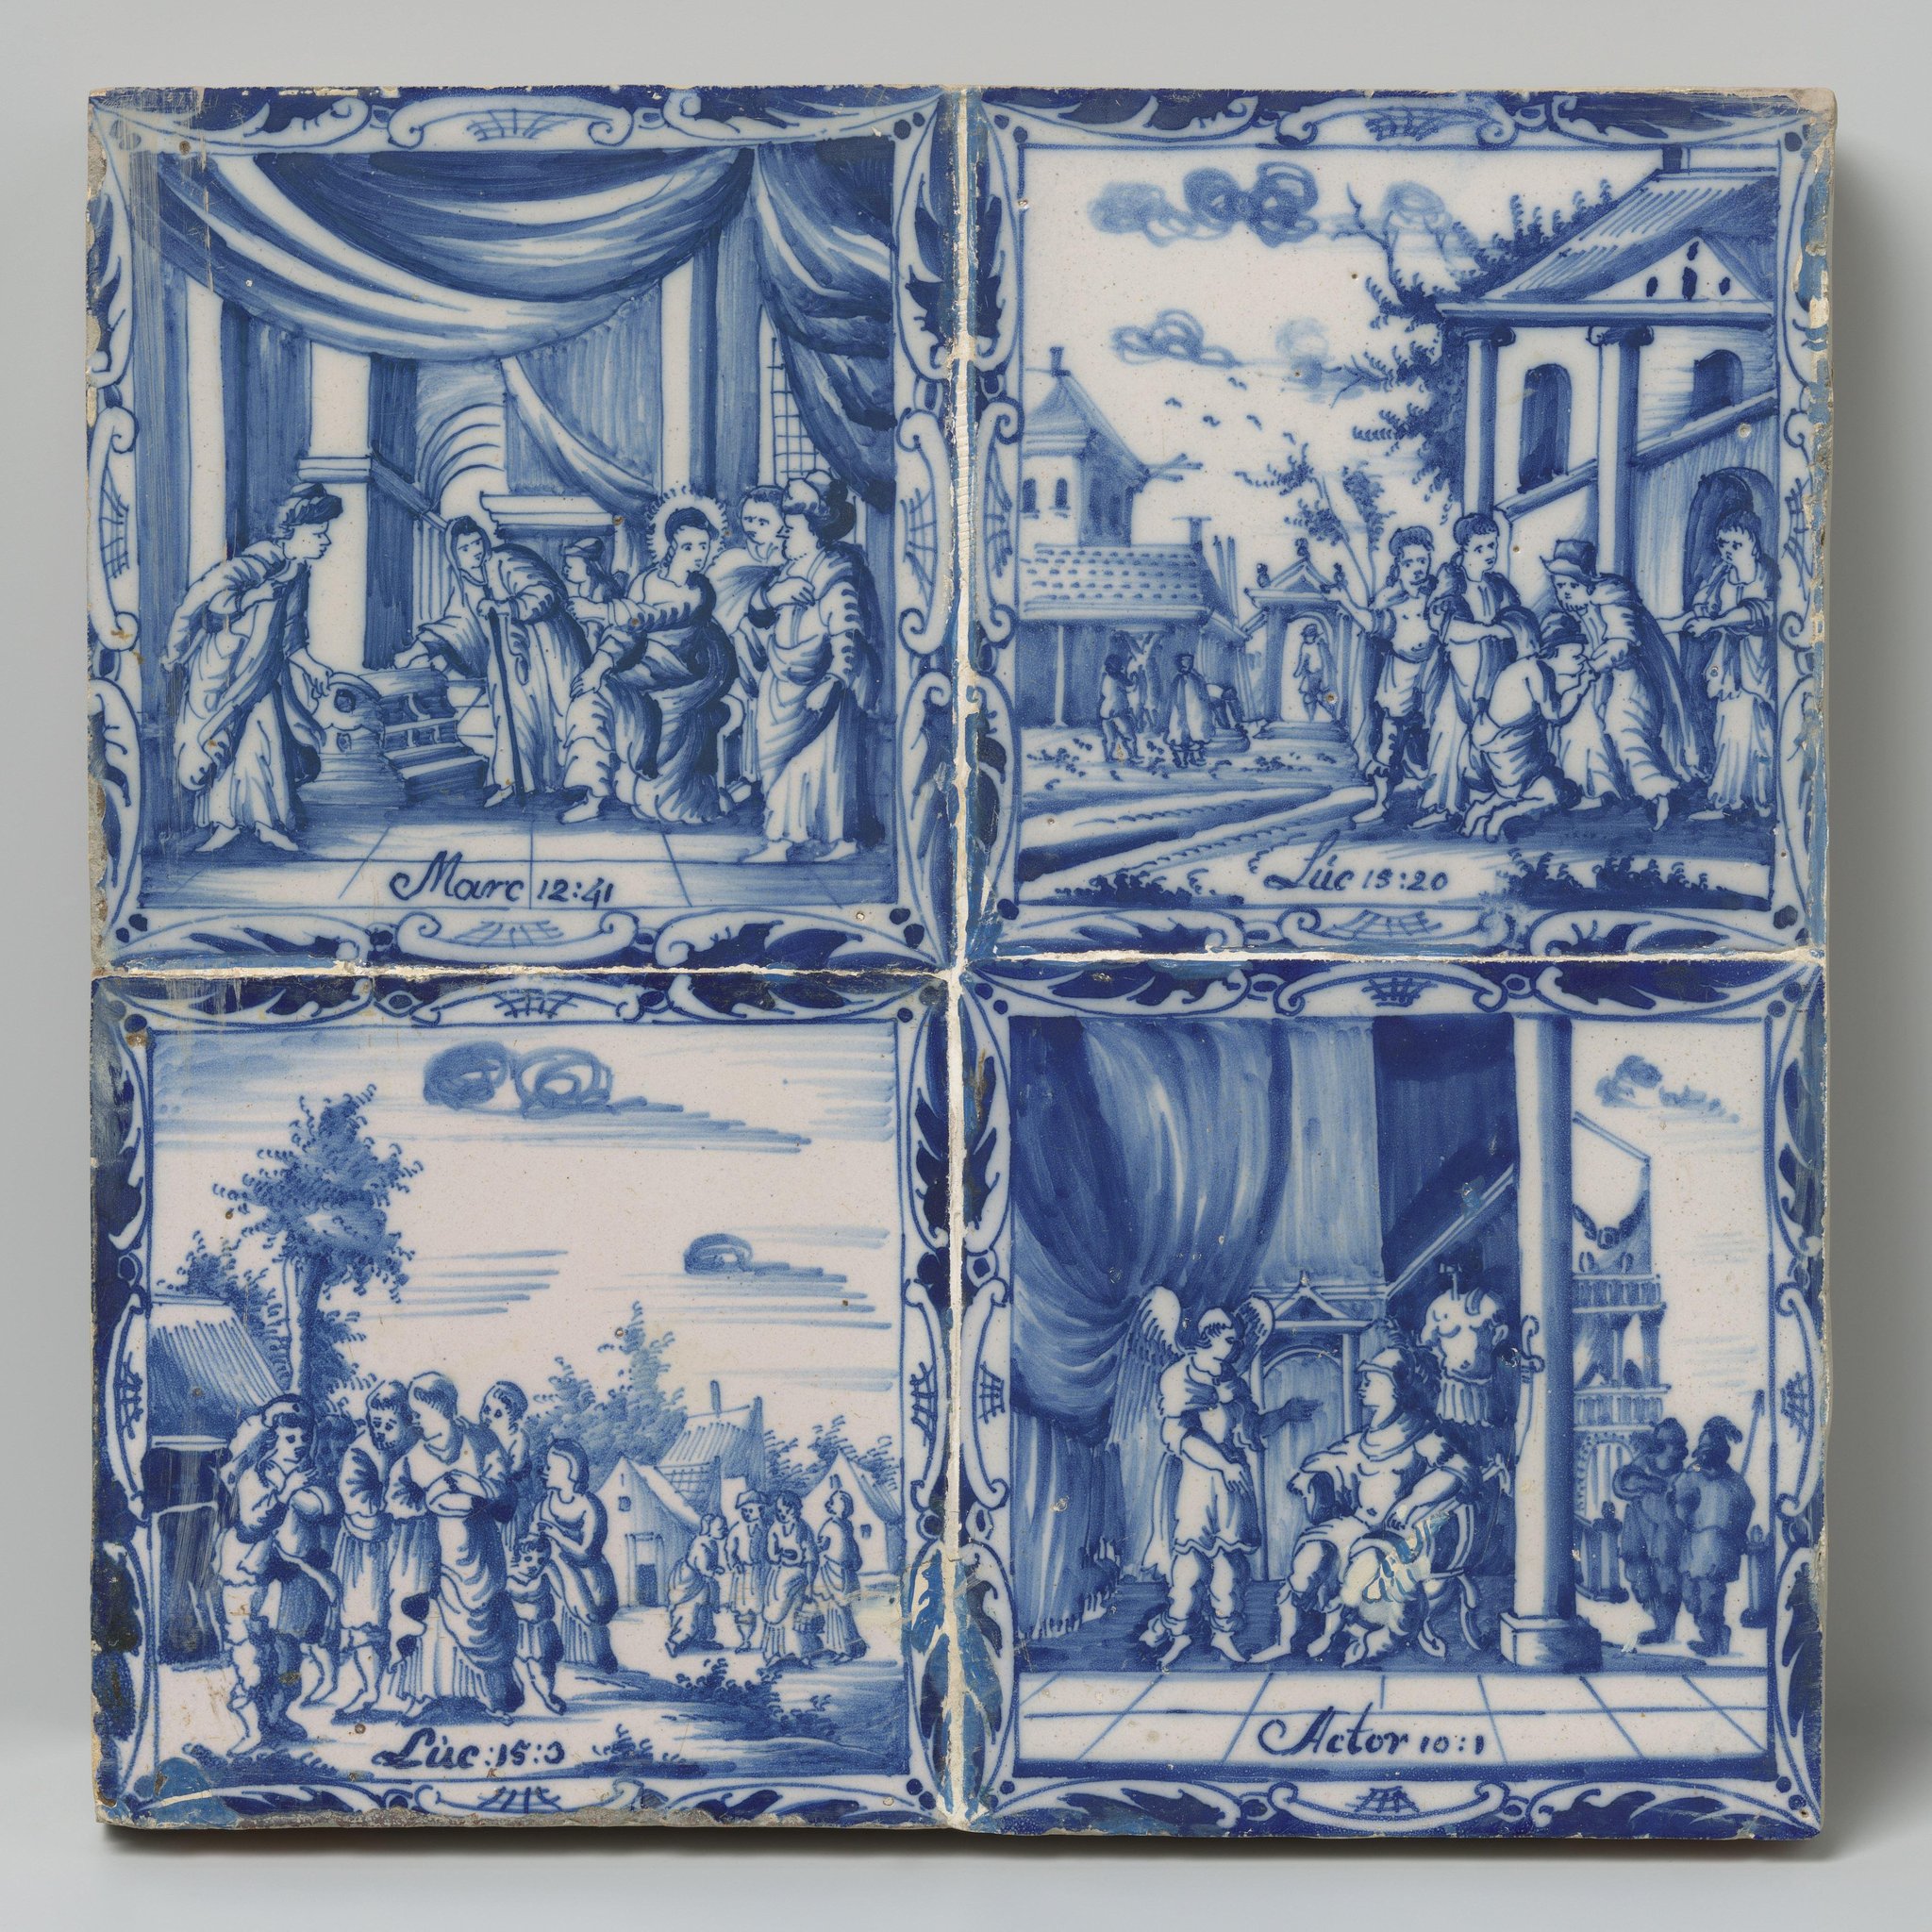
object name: tile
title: Tegel met de verloren zoon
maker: Anonymous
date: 1740-1780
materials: earthenware, glaze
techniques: maiolica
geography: netherlands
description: Tegel met een blauw geschilderde bijbelse voorstelling, de verloren zoon met het opschrift: Luc 15:20. De voorstelling is omlijst door bladeren en c-voluten. Deze tegel vormt onderdeel van een veld van 2 x 2 tegels samen met BK-15579, 15580 en 15582.